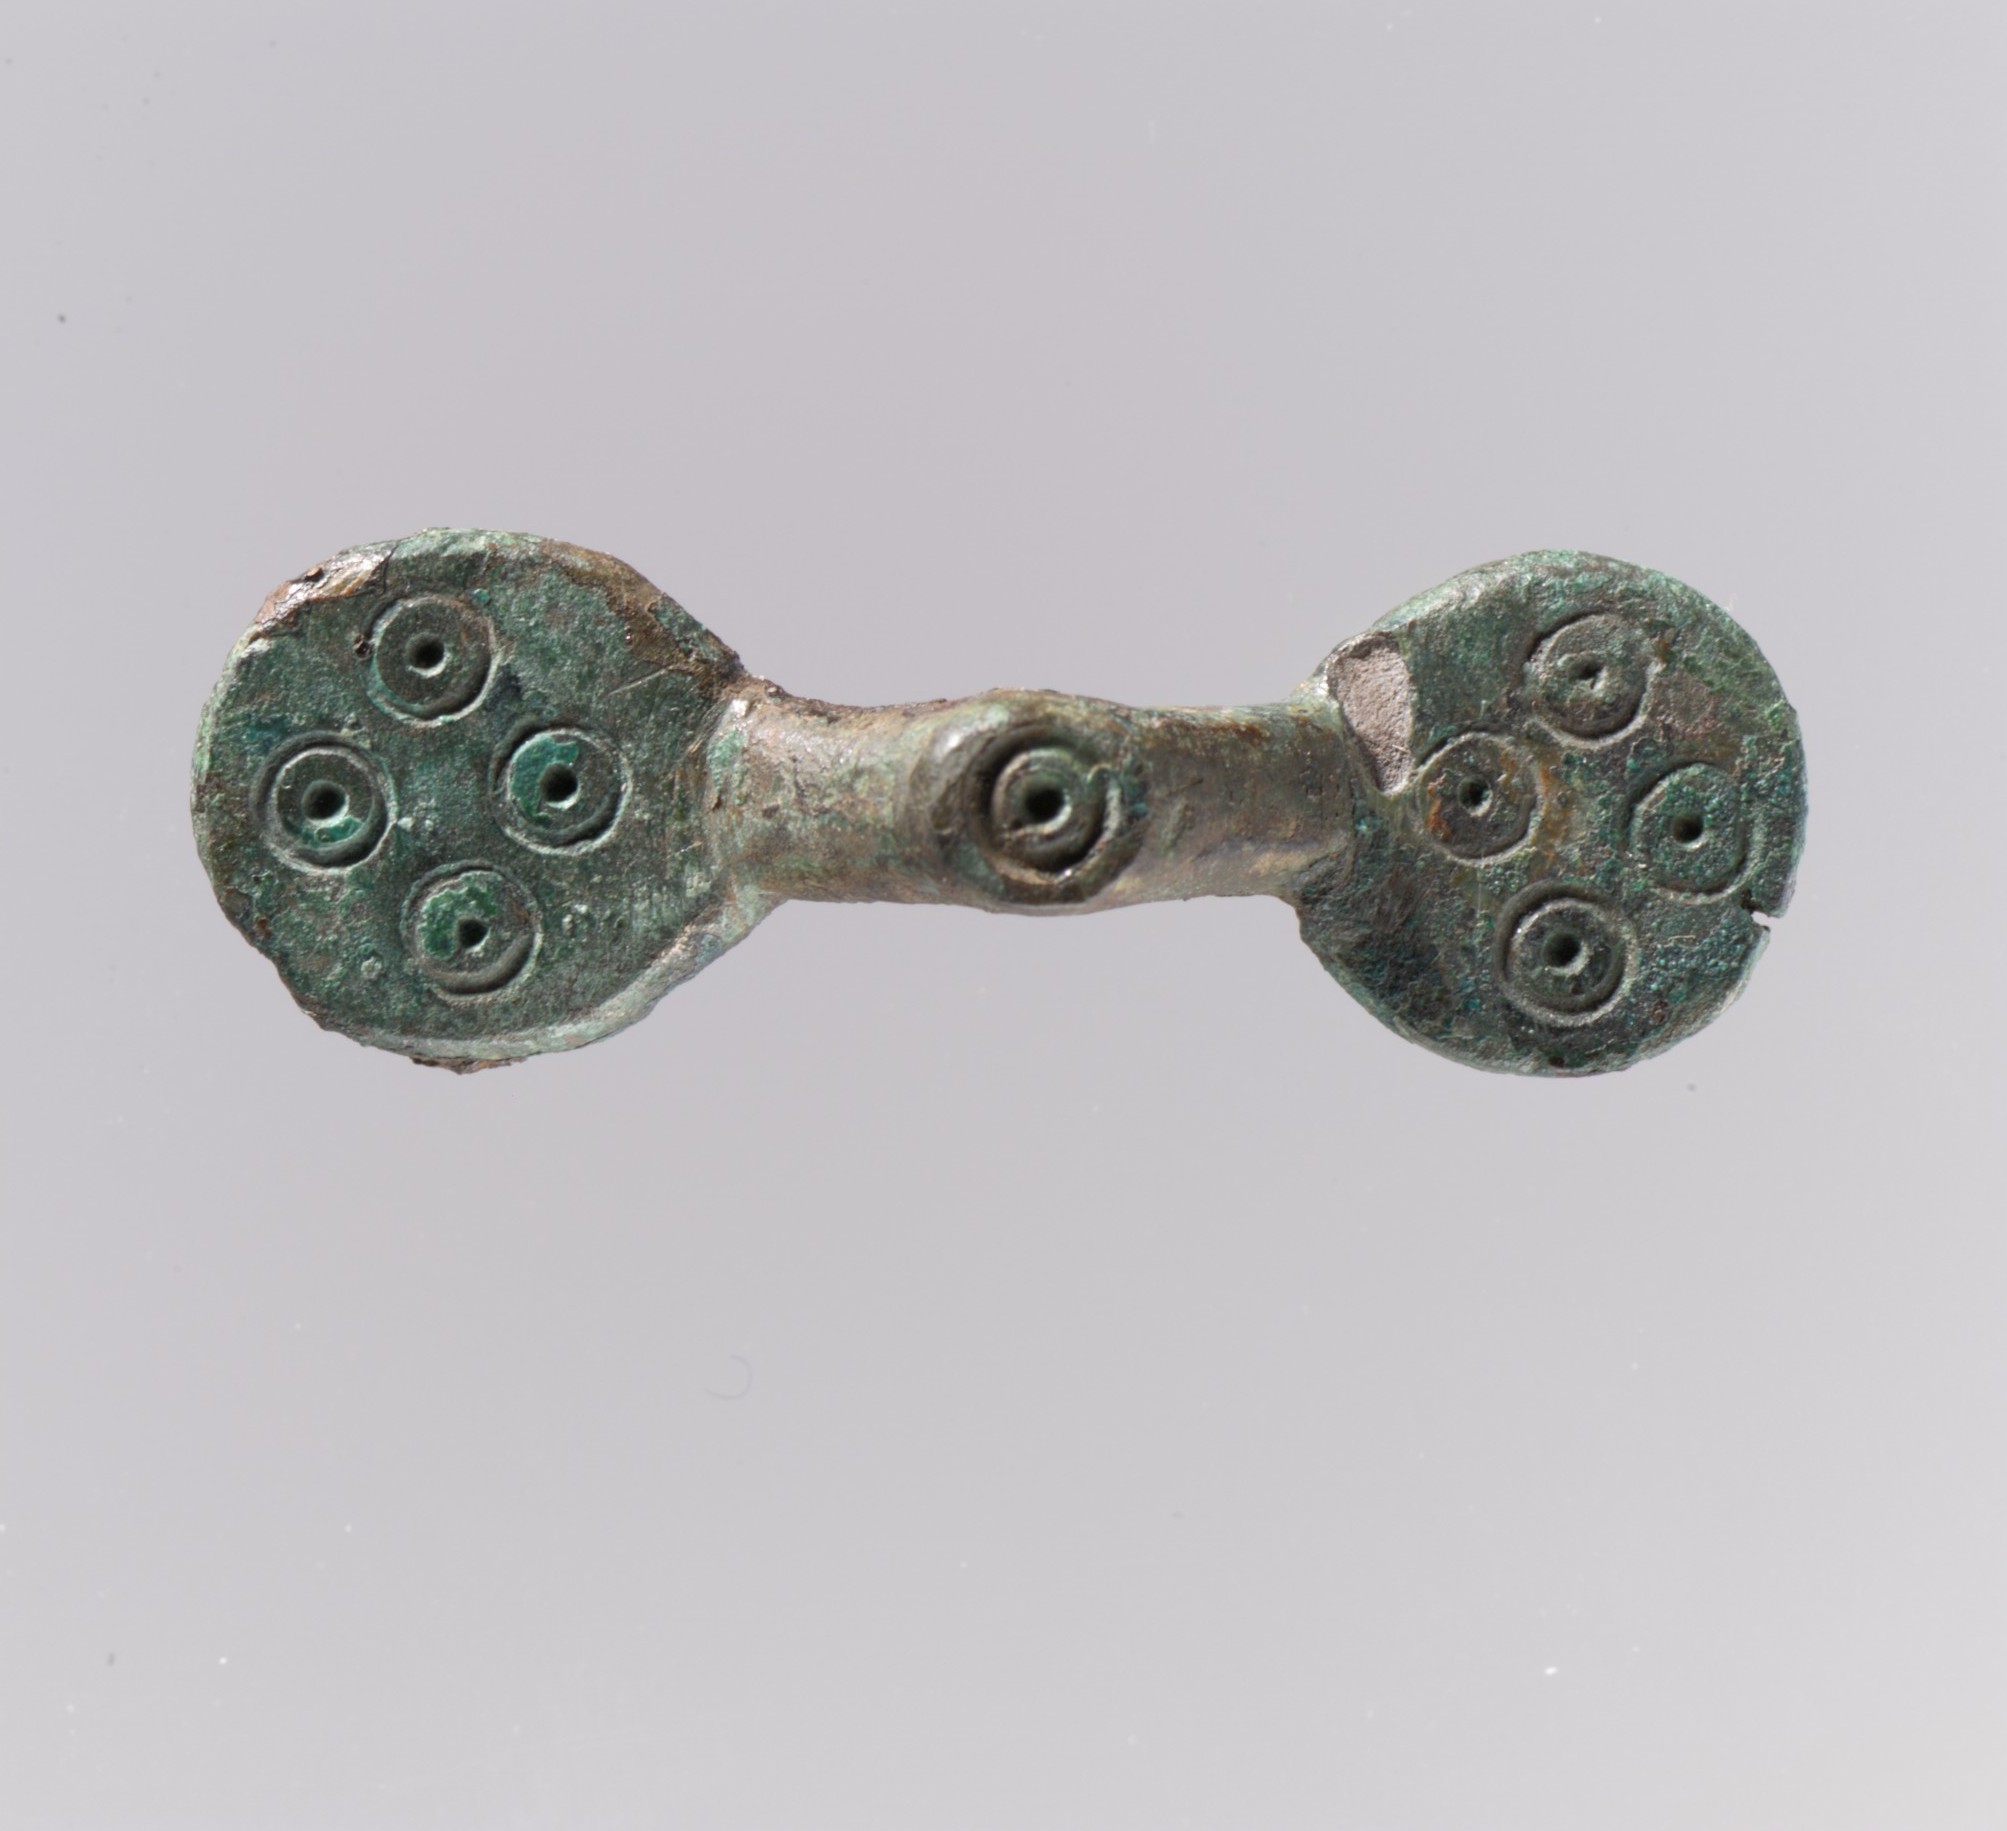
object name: brooch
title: Equal-Arm Brooch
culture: frankish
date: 601-800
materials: copper alloy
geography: northern france